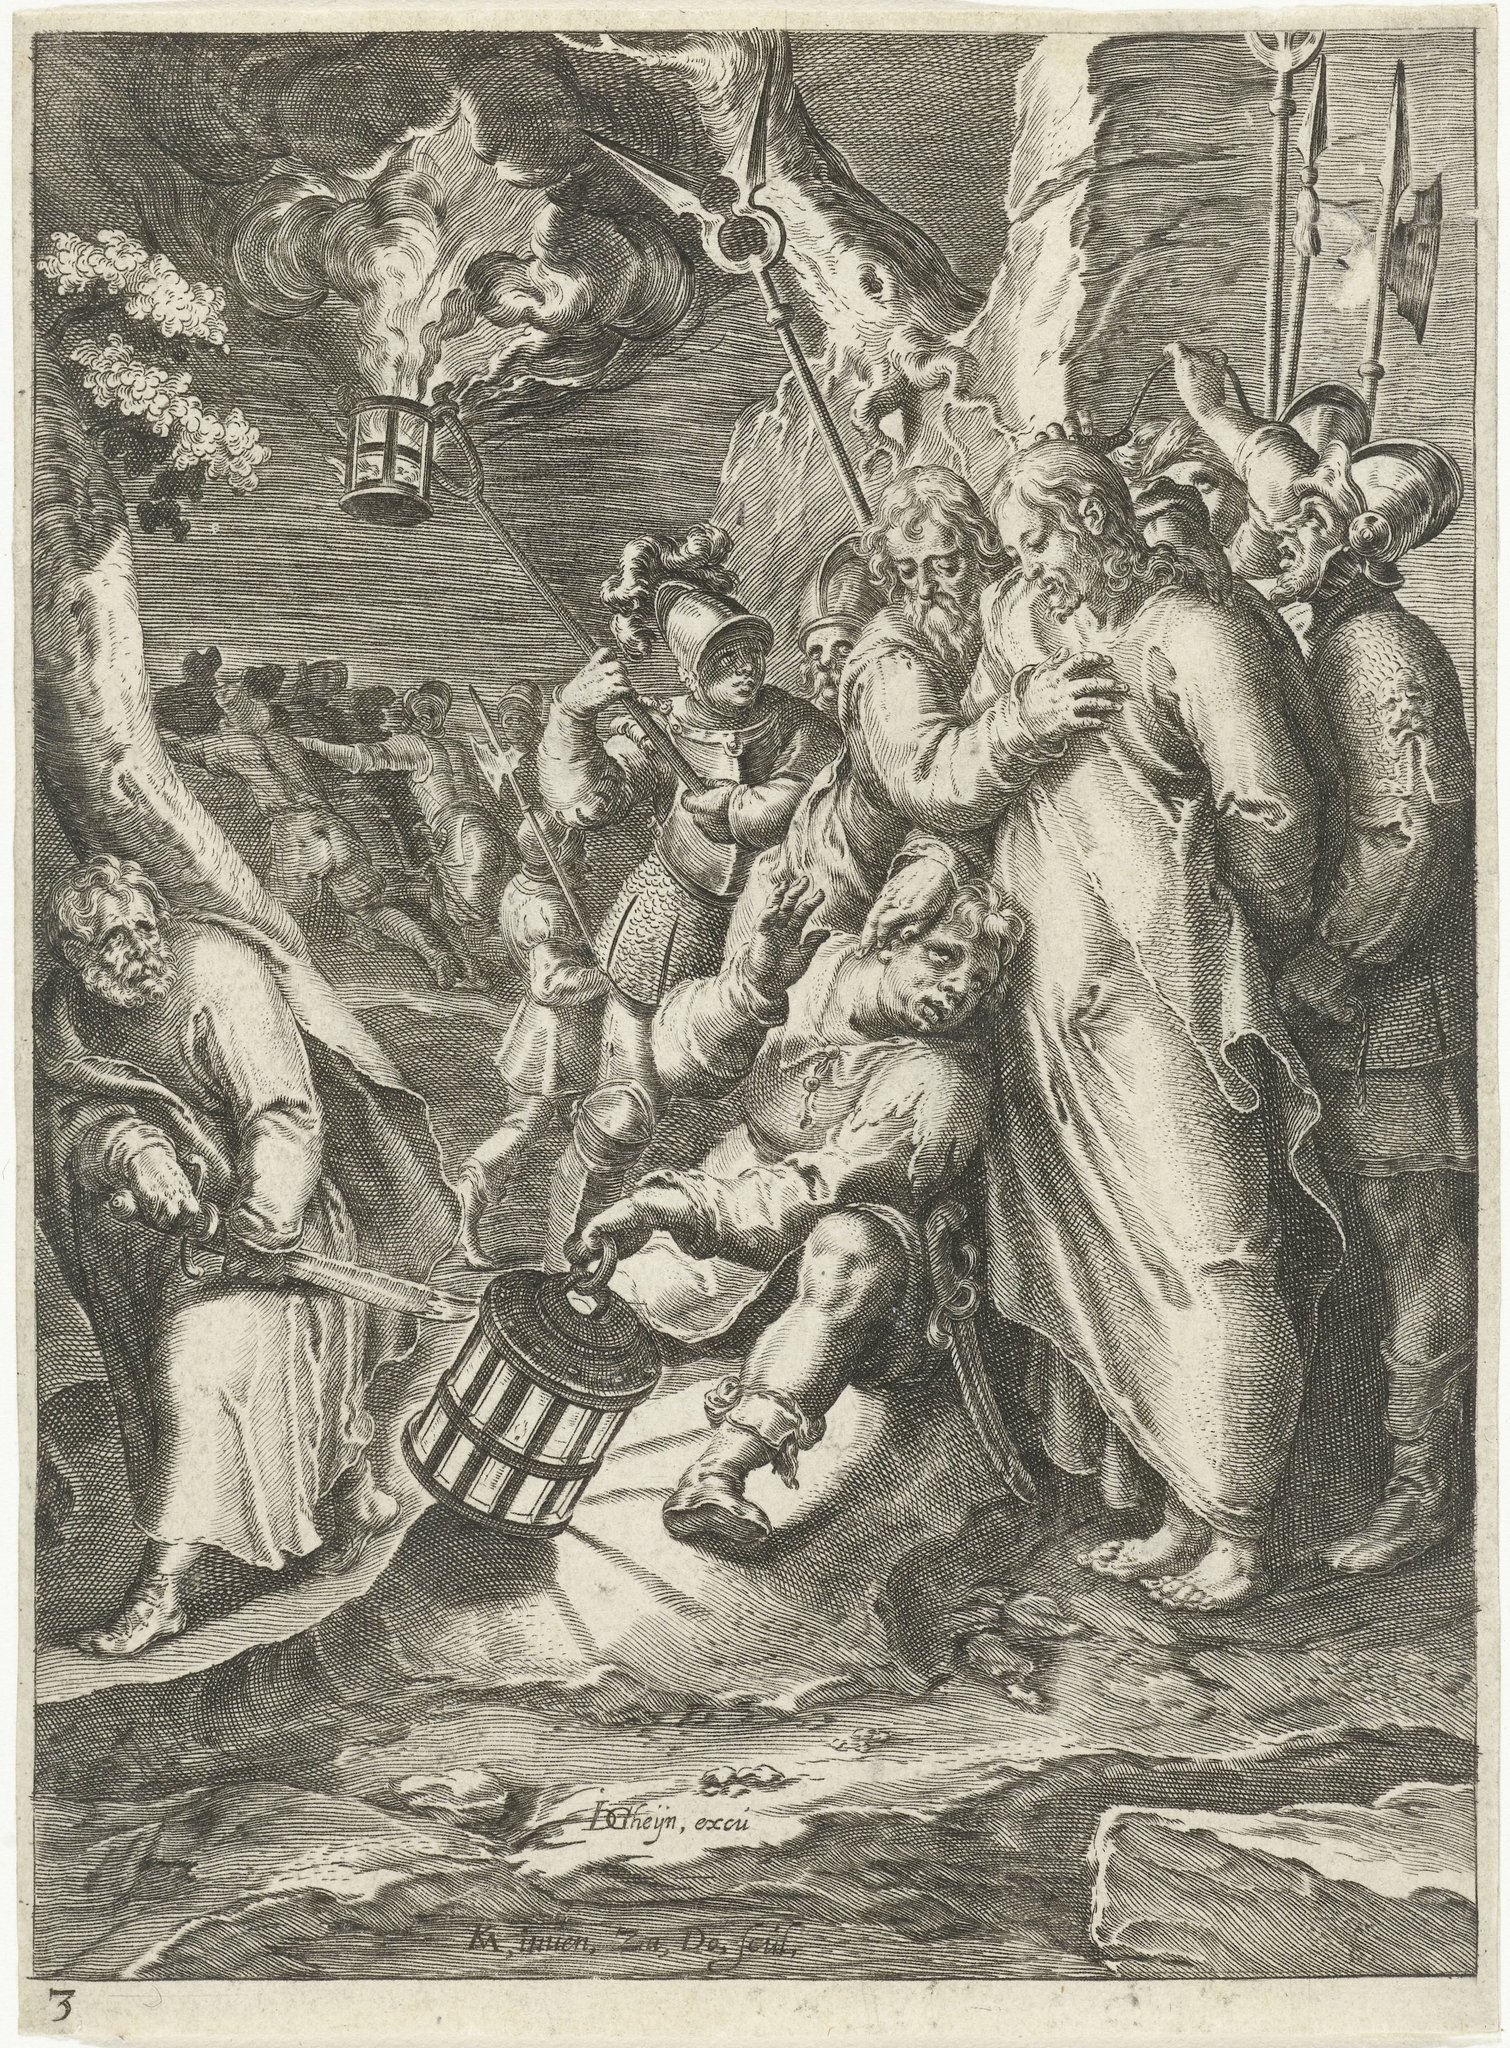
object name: print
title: Gevangenneming van Christus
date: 1596-1598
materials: paper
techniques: engraving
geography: leiden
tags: the arrest of christ ~ garden of gethsemane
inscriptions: collector's mark: Lugt 2228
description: Christus wordt 's nachts gevangen genomen door de soldaten. Twee van zijn discipelen drukken zich tegen het lichaam van Christus aan om hem te beschermen. Een soldaat bindt de handen van Christus op zijn rug met een touw vast. Prent uit een serie van 13 prenten en een titelprent vervaardigt door Z. Dolendo en J. de Gheyn II.